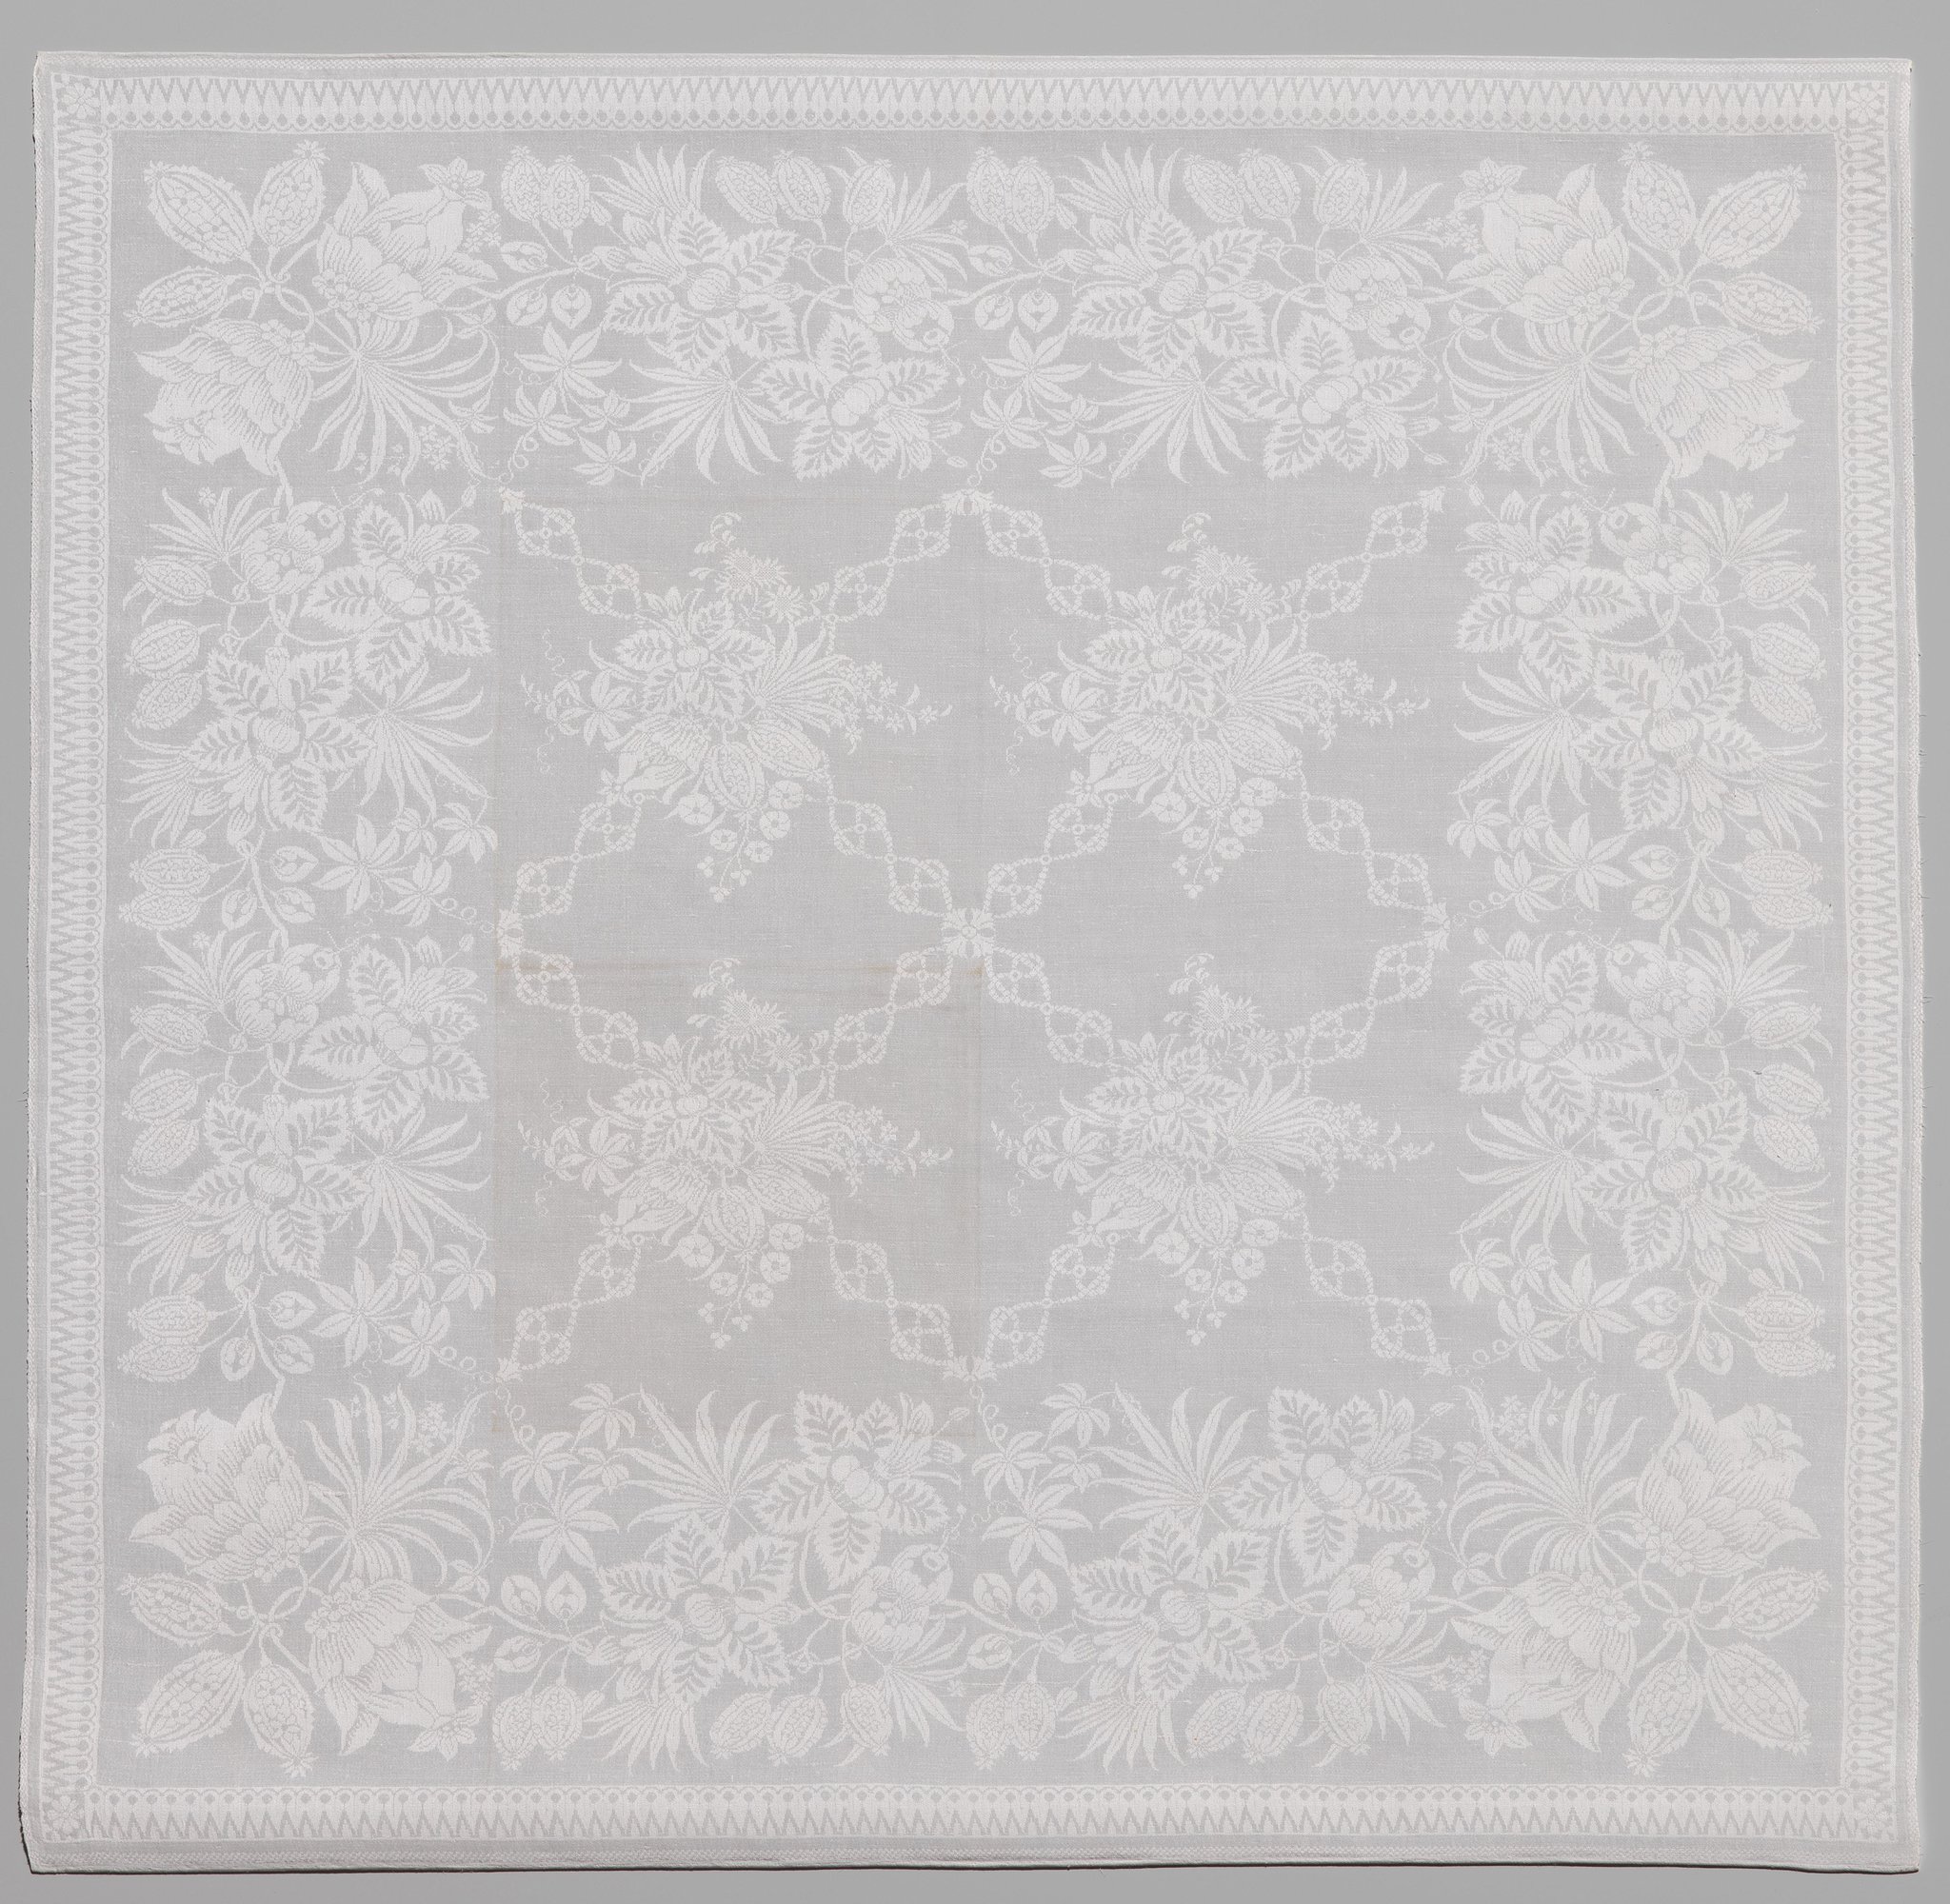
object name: napkin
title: Bloempatroon. Merk: WH 2oonl.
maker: Anonymous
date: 1850-1899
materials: linen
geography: netherlands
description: Servet van wit linnen met een bloempatroon. Merk: WH 2oonl.